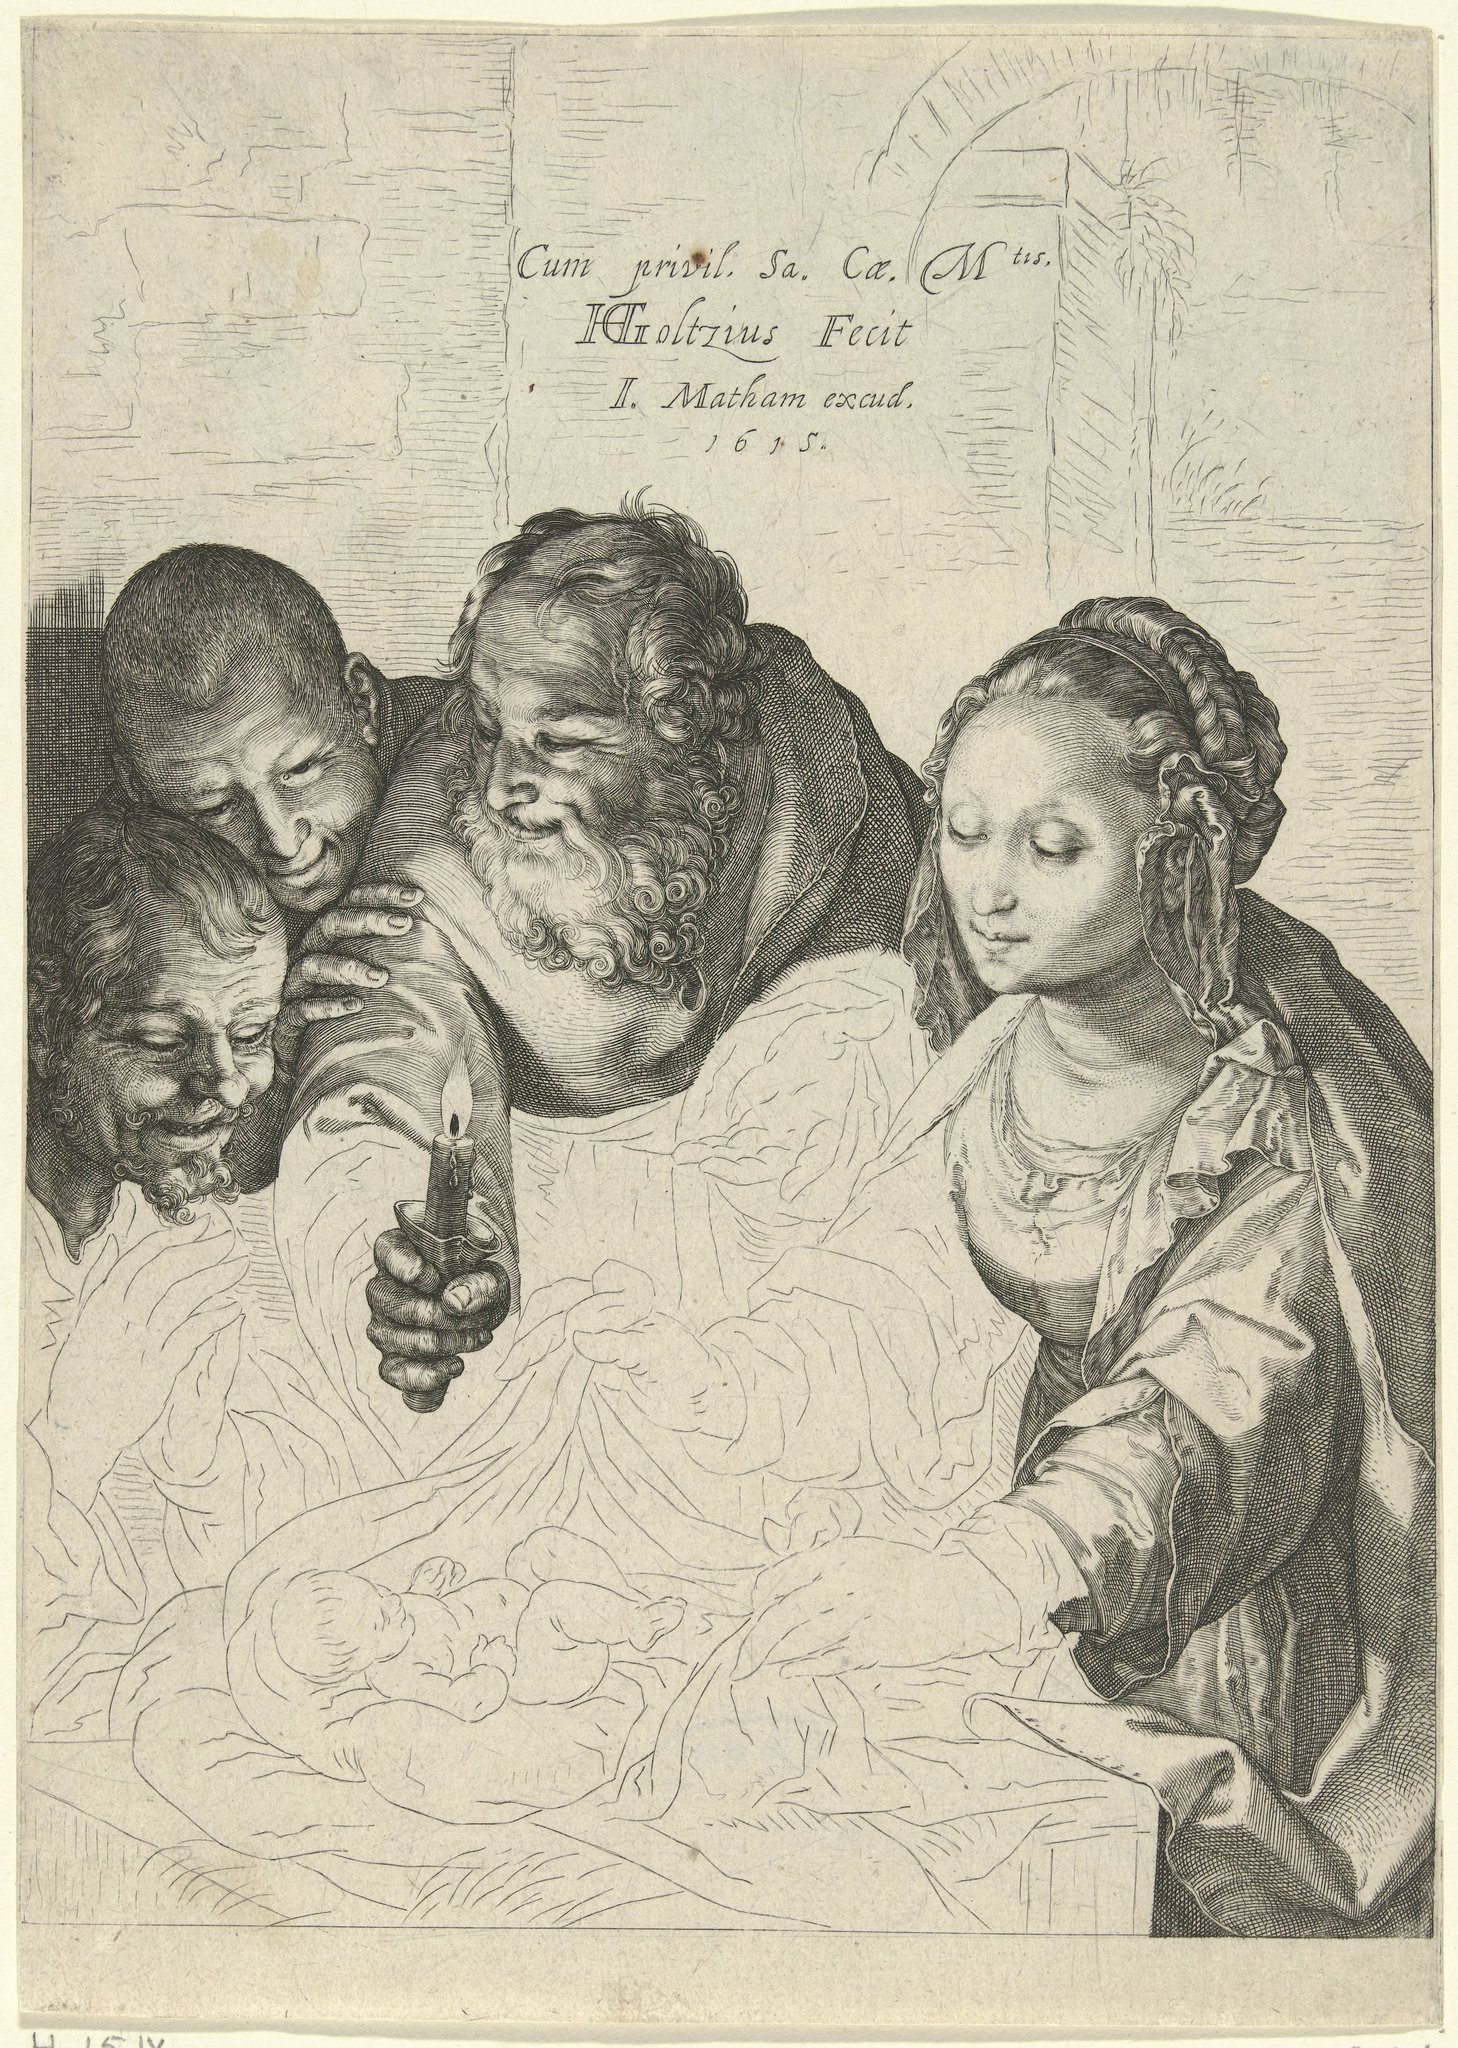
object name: print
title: Aanbidding door de herders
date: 1615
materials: paper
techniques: engraving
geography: haarlem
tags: adoration of the christ-child by the shepherds; mary and joseph present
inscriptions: collector's mark: Lugt 2228a, signature, date and inscription: ‘Cum privil. Sa. Cae. Mtis / HGoltzius Fecit/ I. Matham excud./ 1615.’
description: Onvoltooide prent van herders die het Christuskind aanbidden. Twee herders, Maria en Jozef zijn afgebeeld, de laatste met een kaars in de hand.